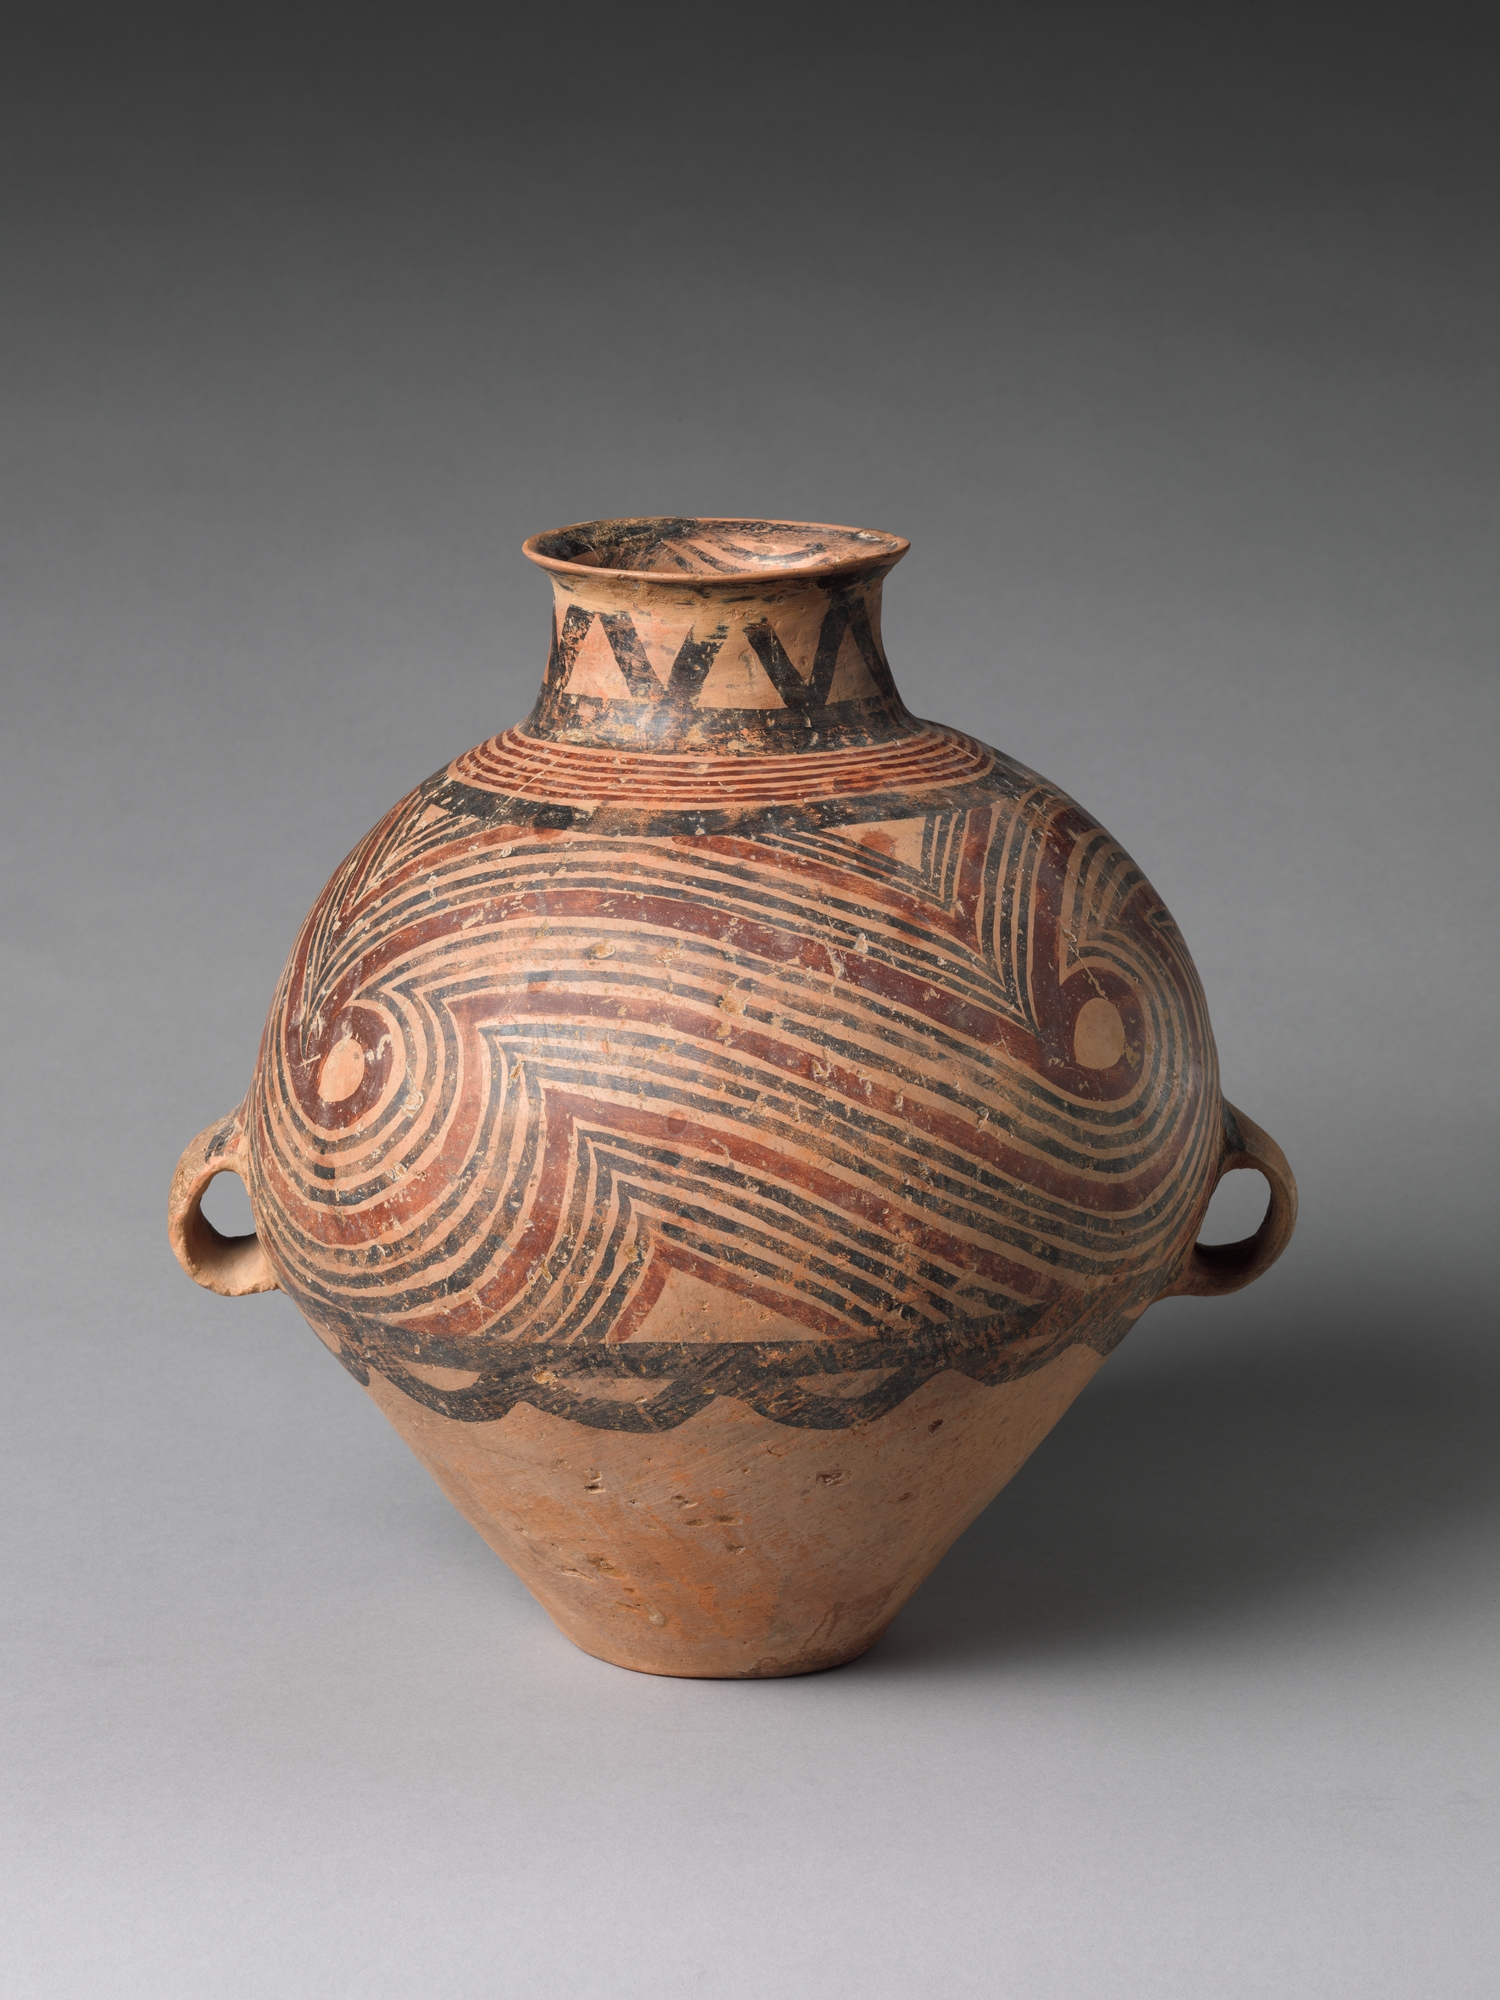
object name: jar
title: Jar (Hu)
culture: chinese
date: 2650-2350 BCE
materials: earthenware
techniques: painting